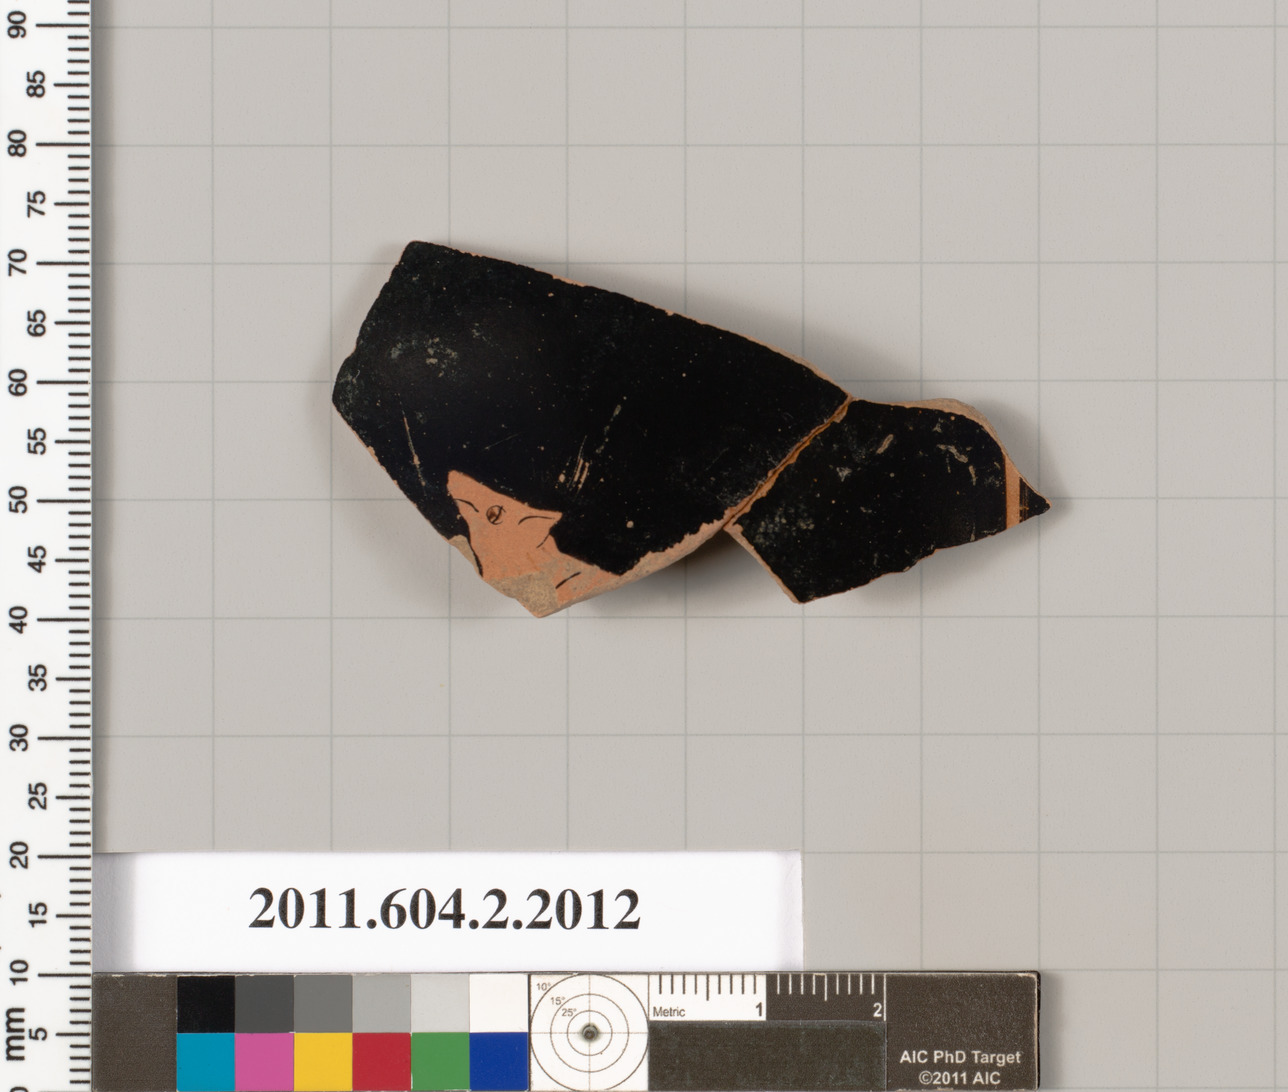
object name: chou fragment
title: Terracotta fragment of an oinochoe: chous (jug)?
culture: greek, attic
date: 460-450 BCE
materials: terracotta